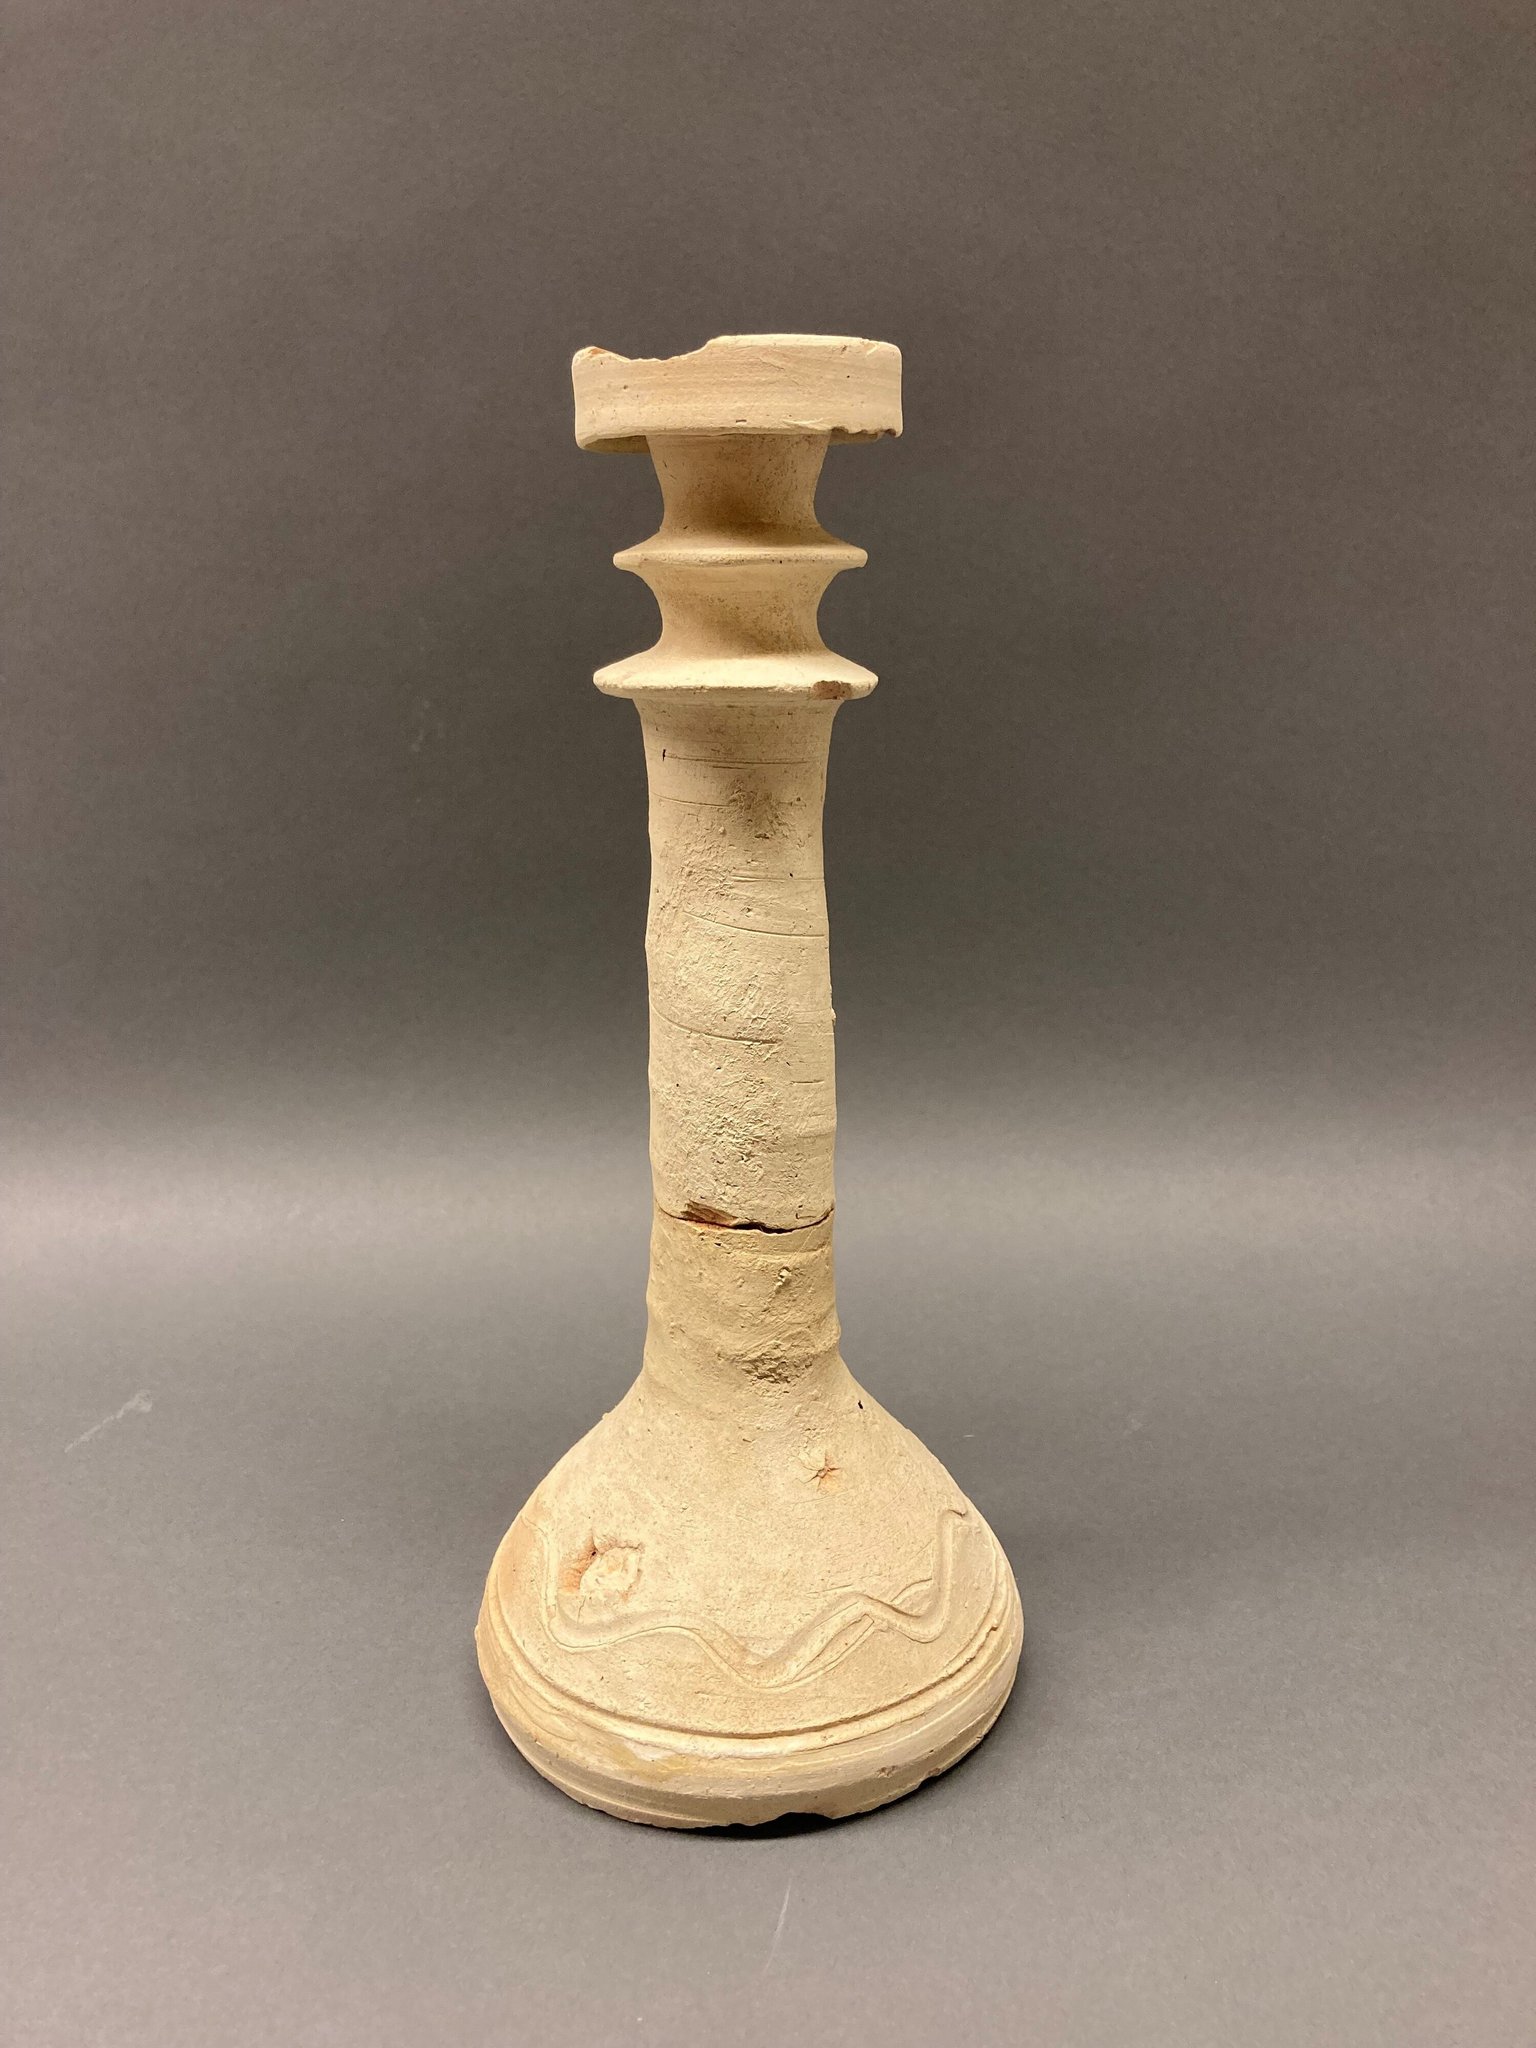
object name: stand or candlestick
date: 867-933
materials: earthenware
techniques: incising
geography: iran